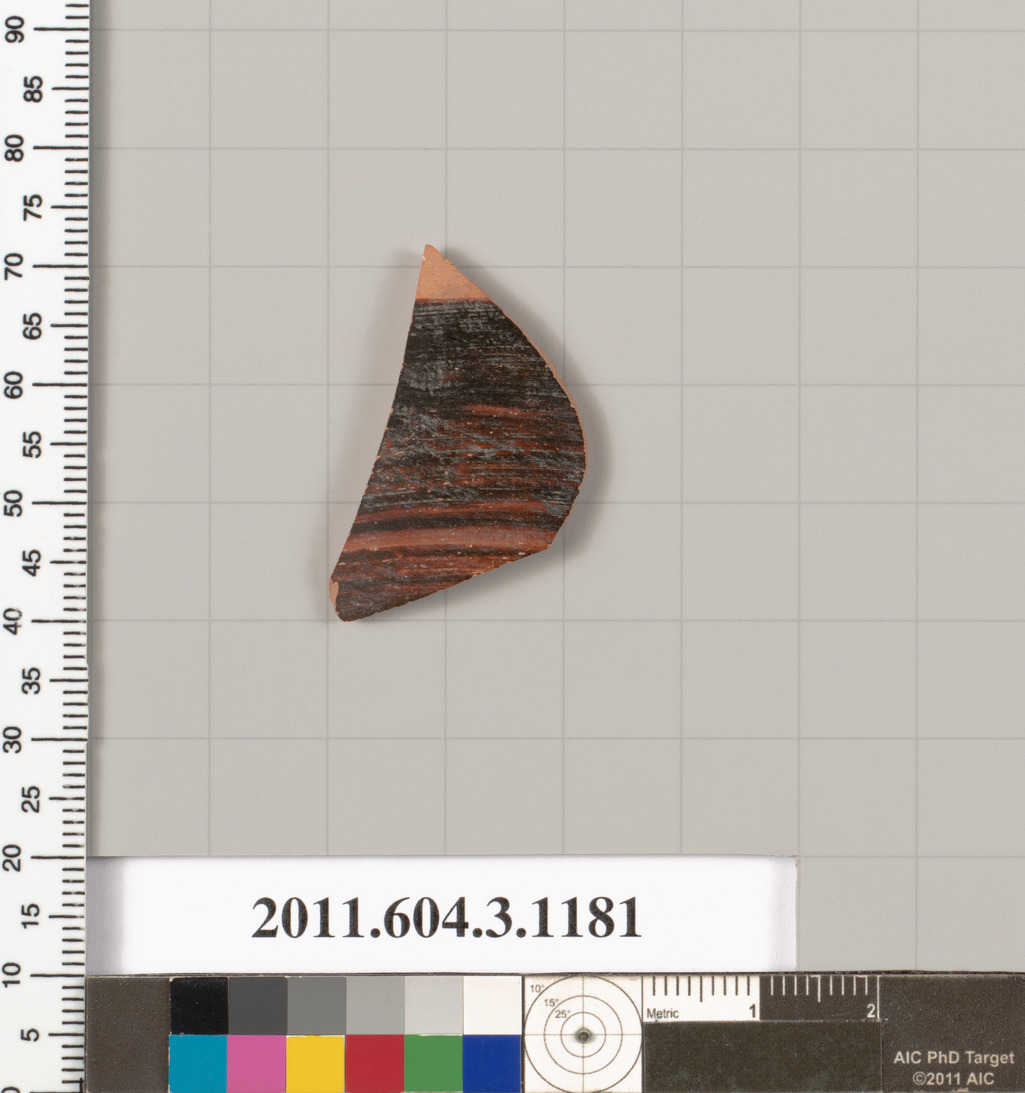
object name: mastoid or kyathos fragment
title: Terracotta fragment of a mastoid (drinking cup with narrow base) or a kyathos (cup-shaped ladle)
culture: greek, attic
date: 534-468 BCE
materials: terracotta